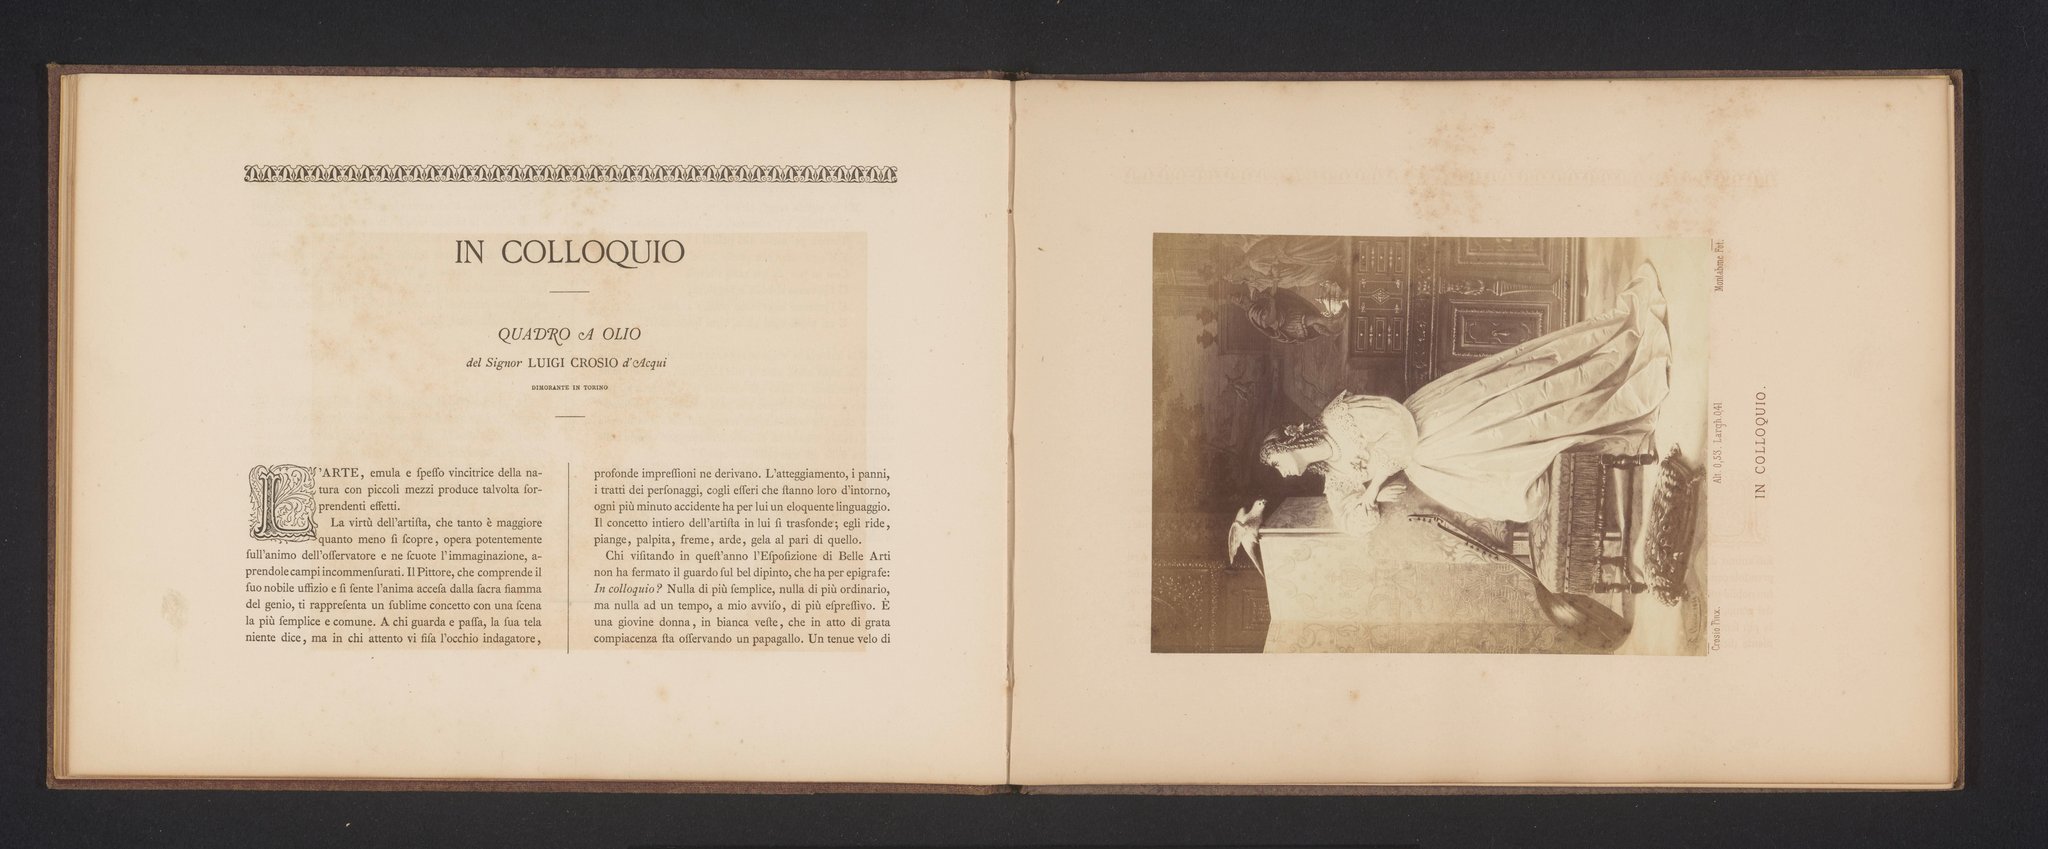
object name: page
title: Fotoreproductie van een schilderij, voorstellende een vrouw met een papegaai in een interieur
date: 1865-1866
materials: photographic support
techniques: albumen print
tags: adult woman, ornamental birds: parrot, interior ~ representation of a building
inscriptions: inscription: ‘Alt. 0,53, Lungh, 0-41’